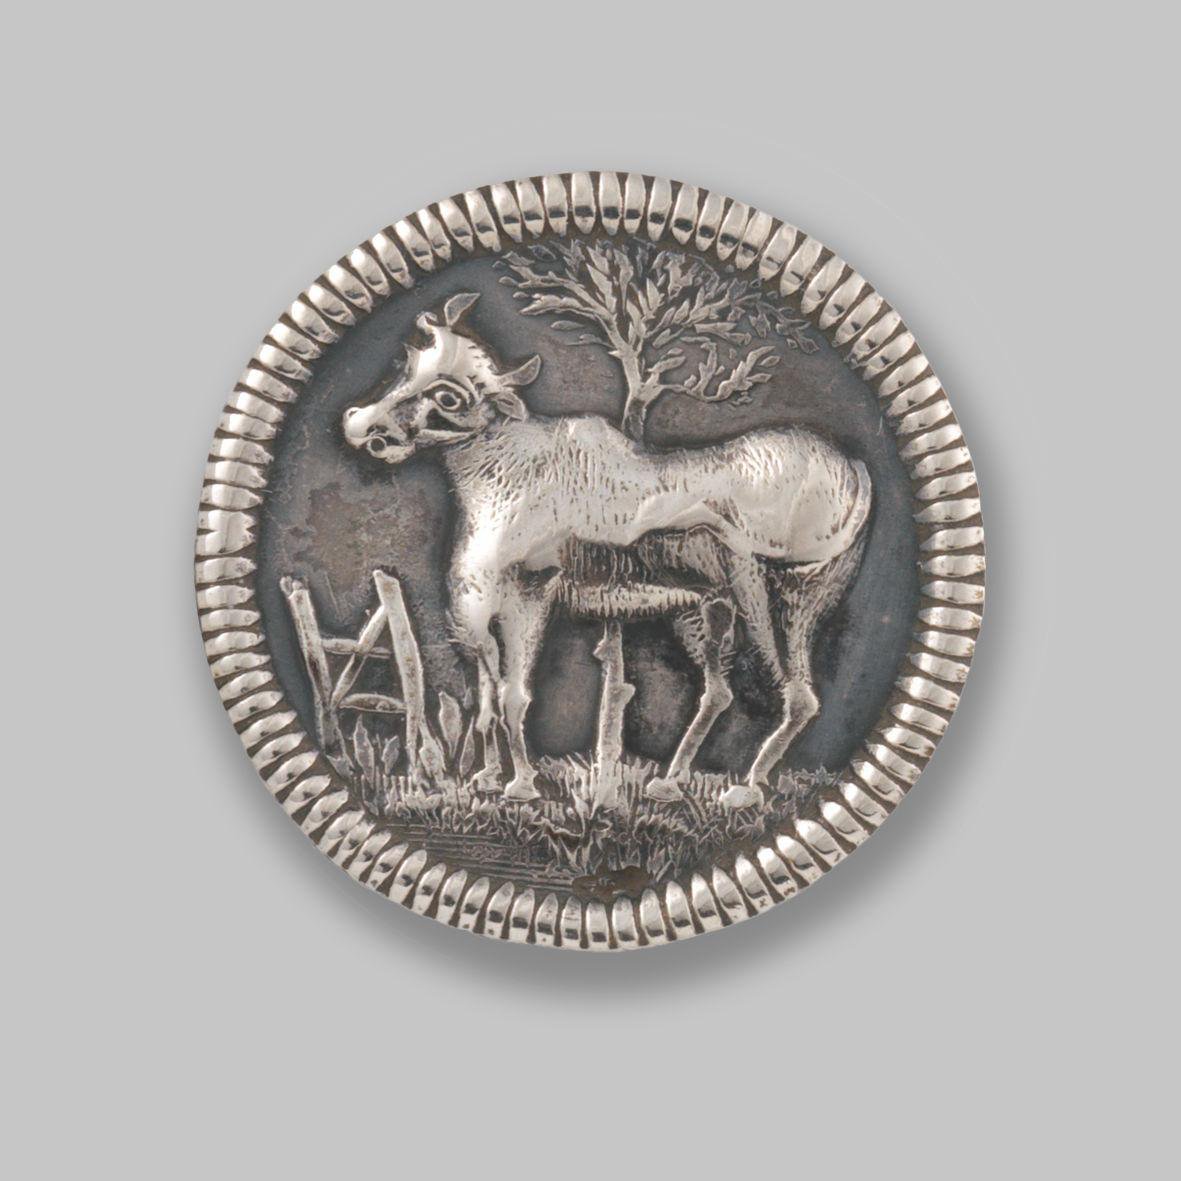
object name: button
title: Knoop met voorstelling van een koe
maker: Anonymous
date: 1850-1900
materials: silver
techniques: casting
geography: netherlands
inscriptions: alloy mark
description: Knoop van gegoten zilver, rond, met op de voorzijde een koe in een weiland omgeven door een geribde rand. Aan de achterzijde is een uit gebogen draad vervaardigd oog bevestigd.